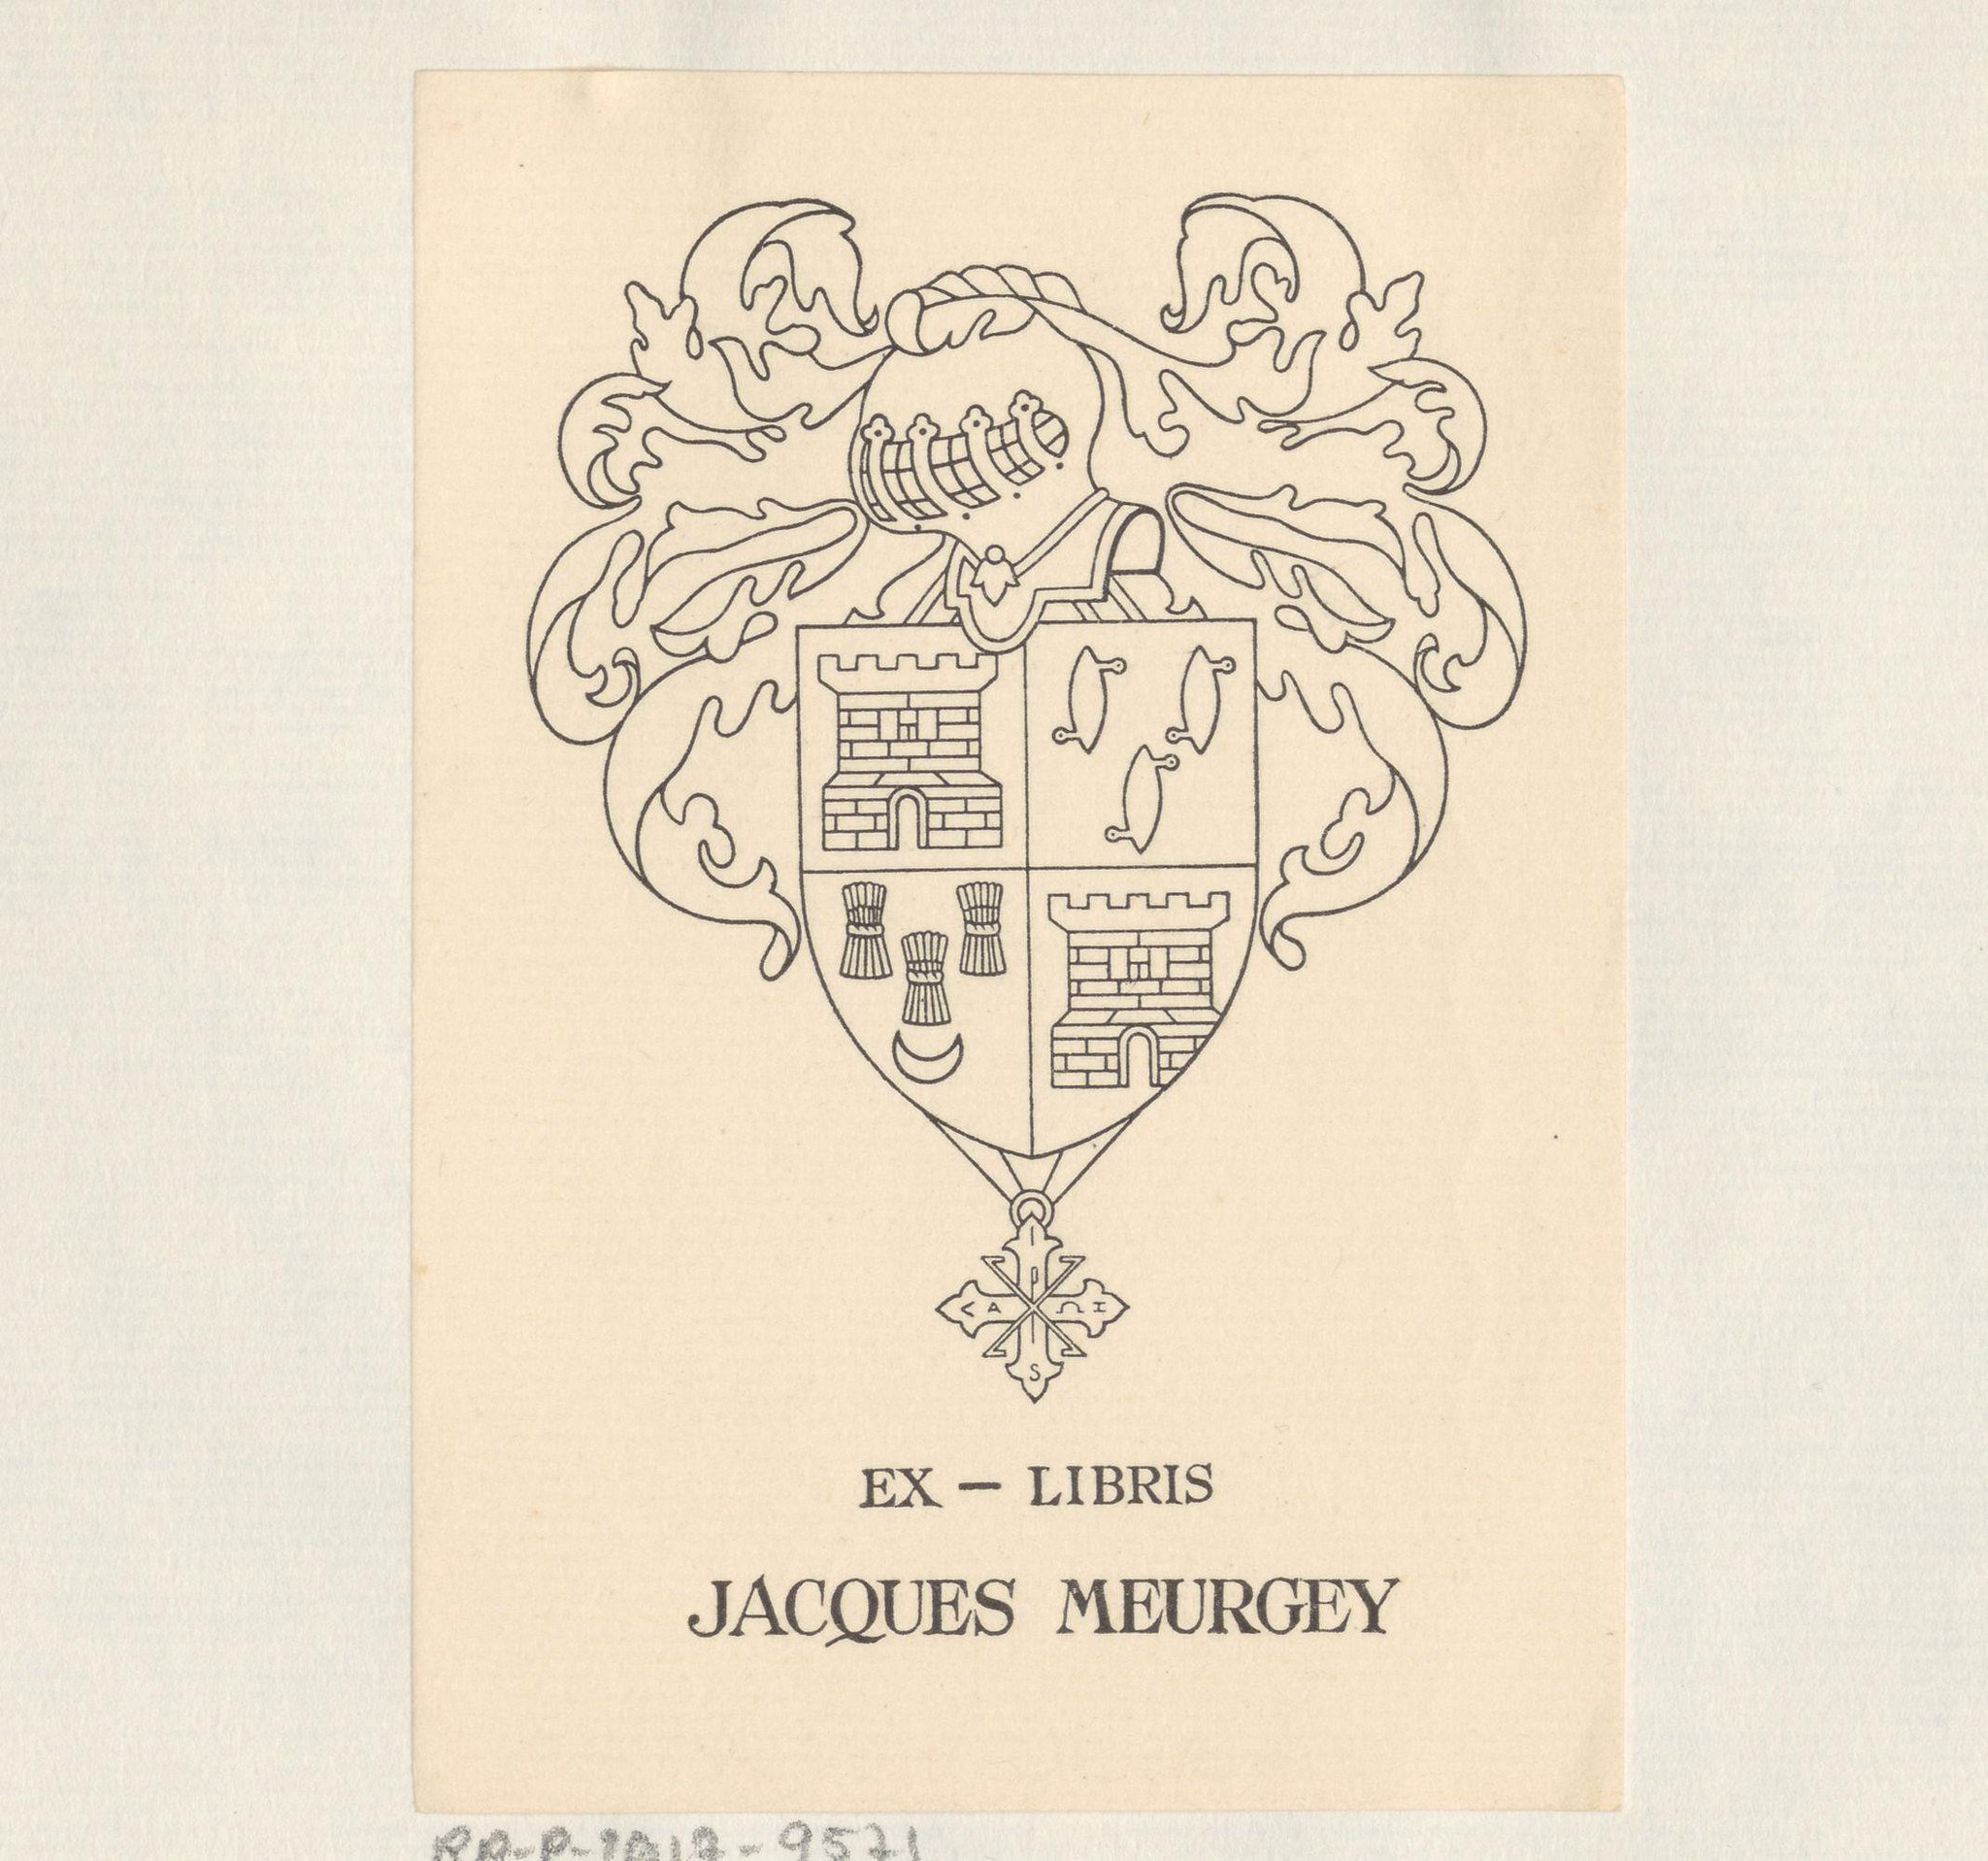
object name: bookplate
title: Ex libris van Jacques Meurgey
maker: Anonymous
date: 1901-1973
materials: paper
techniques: printing block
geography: france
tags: armorial bearing, heraldry